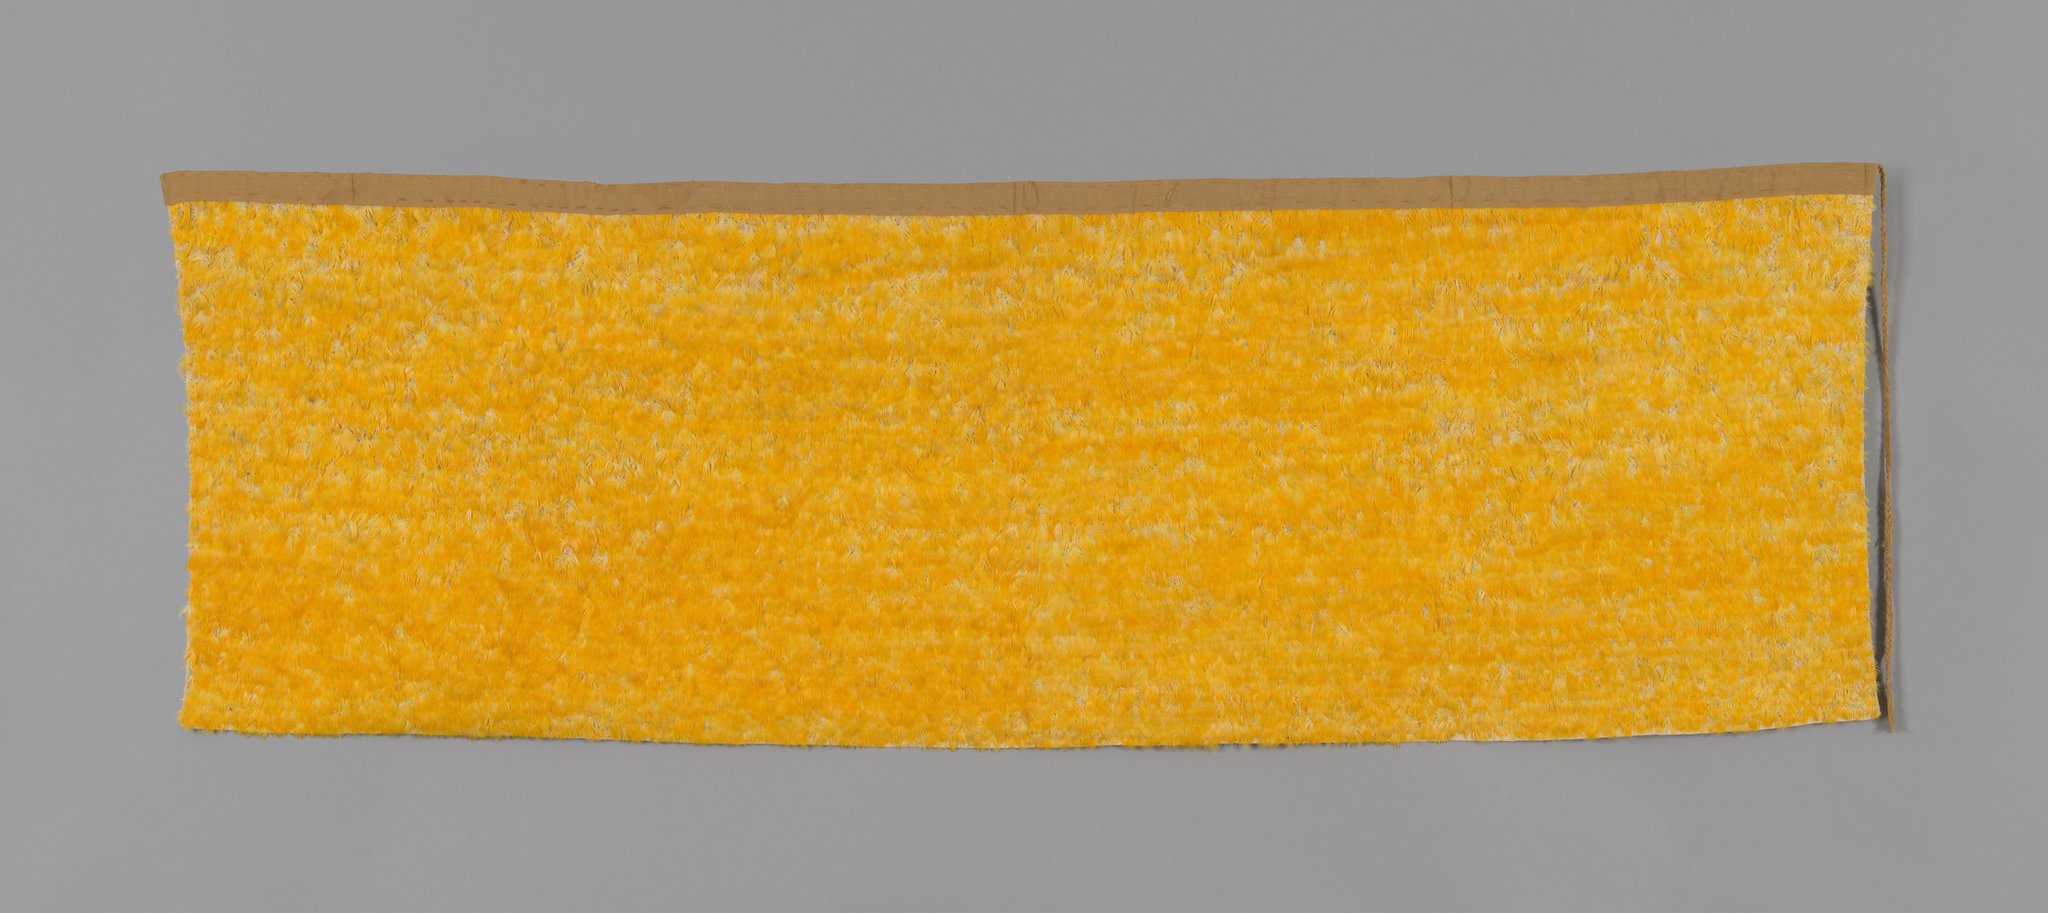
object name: panel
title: Feathered Panel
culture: wari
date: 601-900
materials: animal fiber, cotton, feather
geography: peru